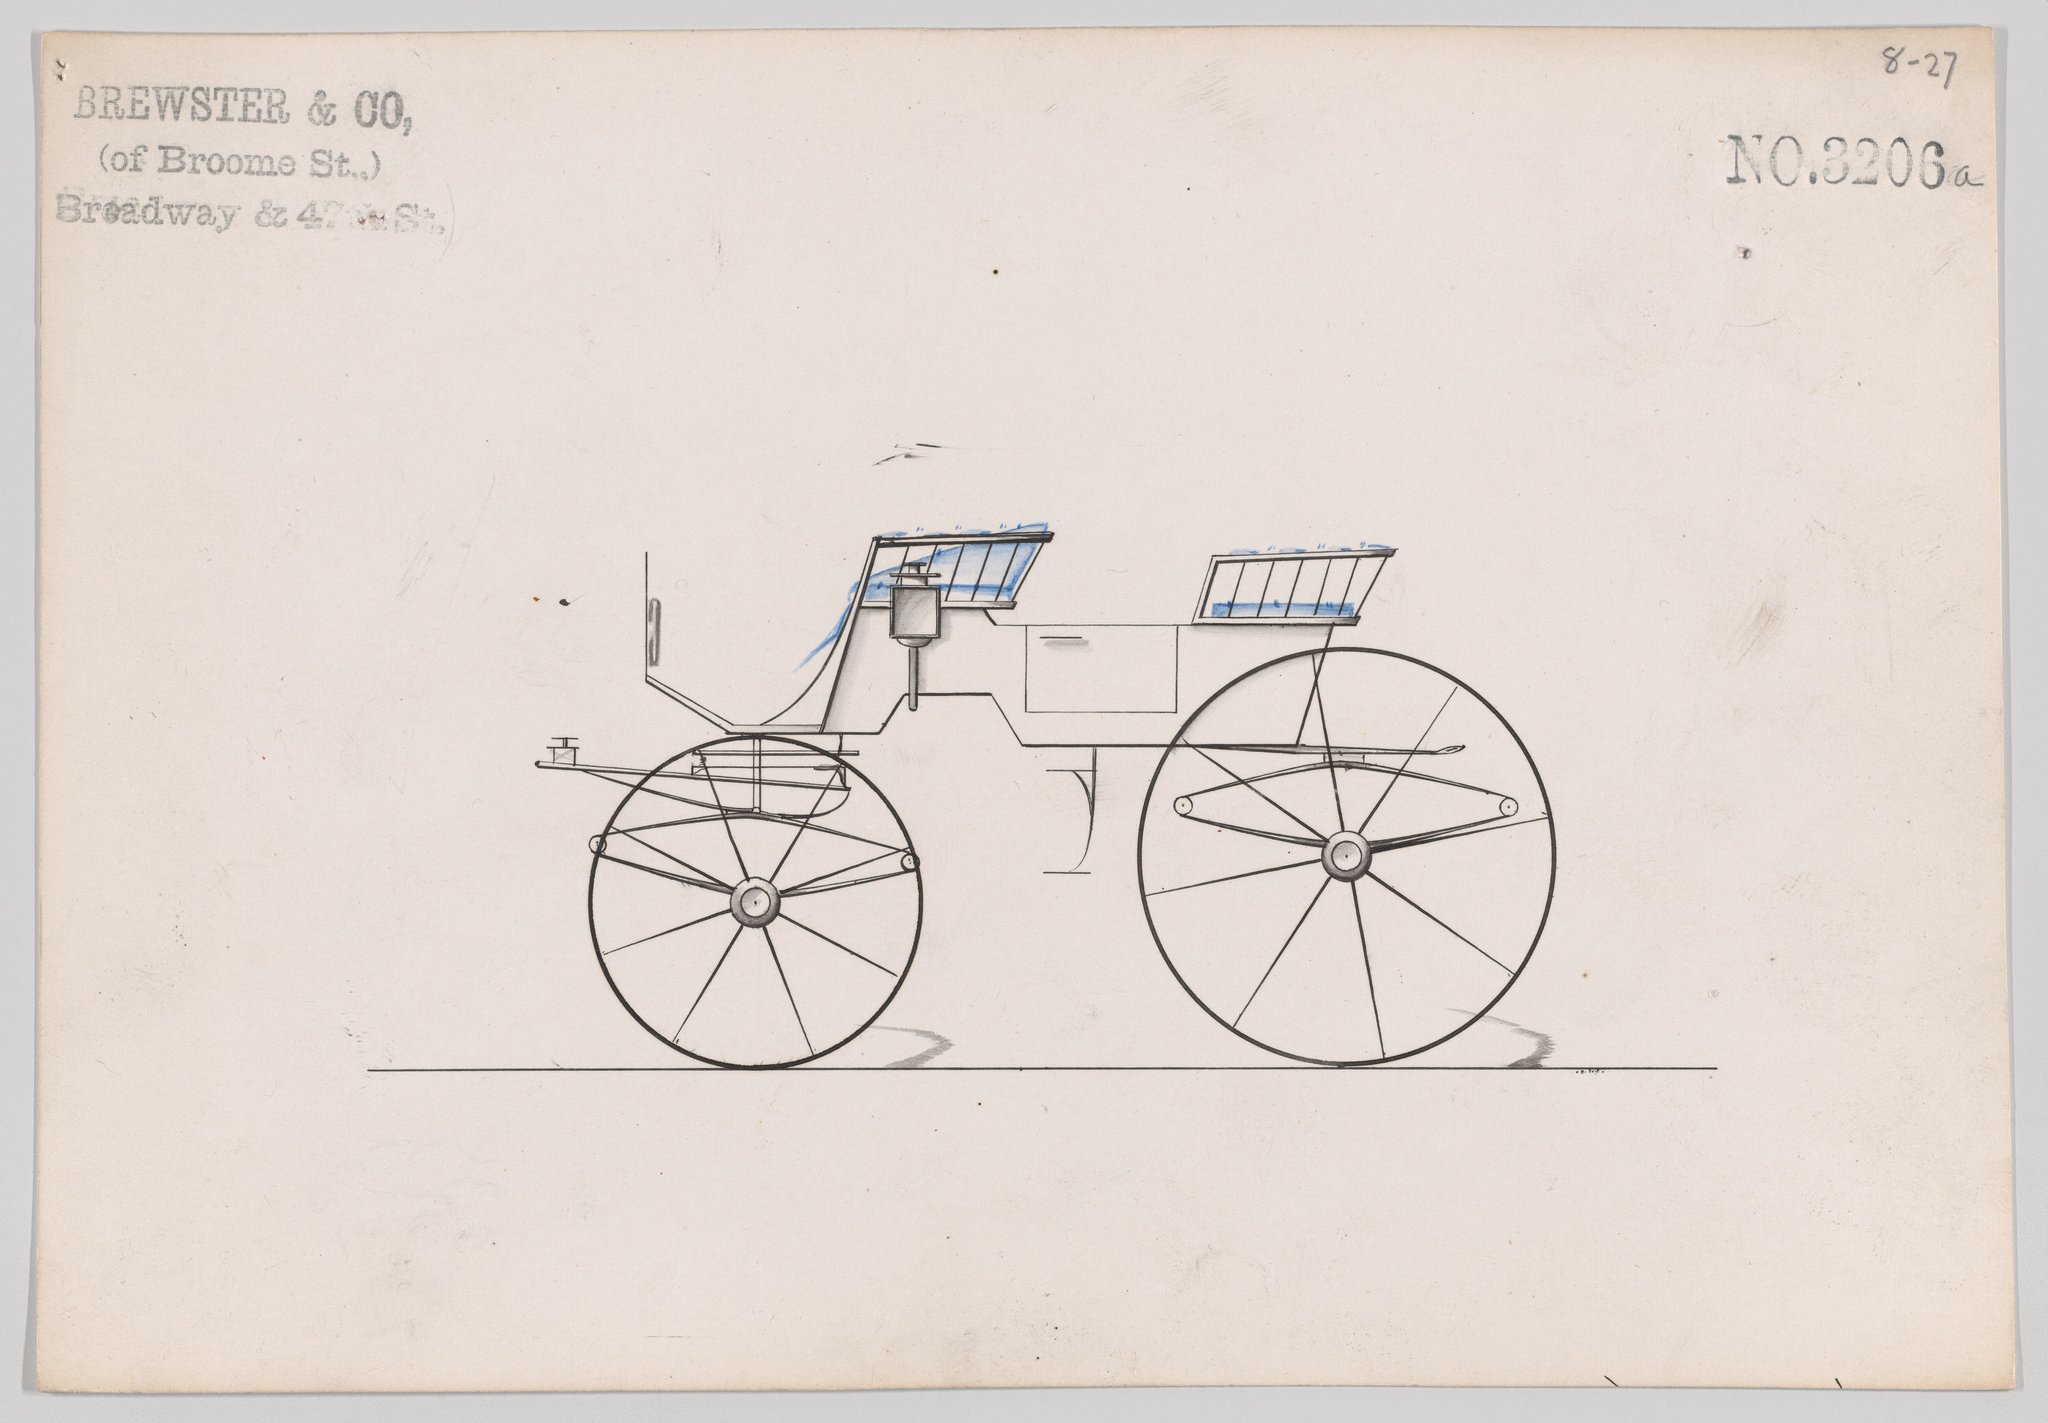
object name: drawing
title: Design for 4 seat Phaeton, no top, no. 3206a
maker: brewster & co.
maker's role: manufacturer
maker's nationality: american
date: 1876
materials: gouache, ink, watercolor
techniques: pen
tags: carriages